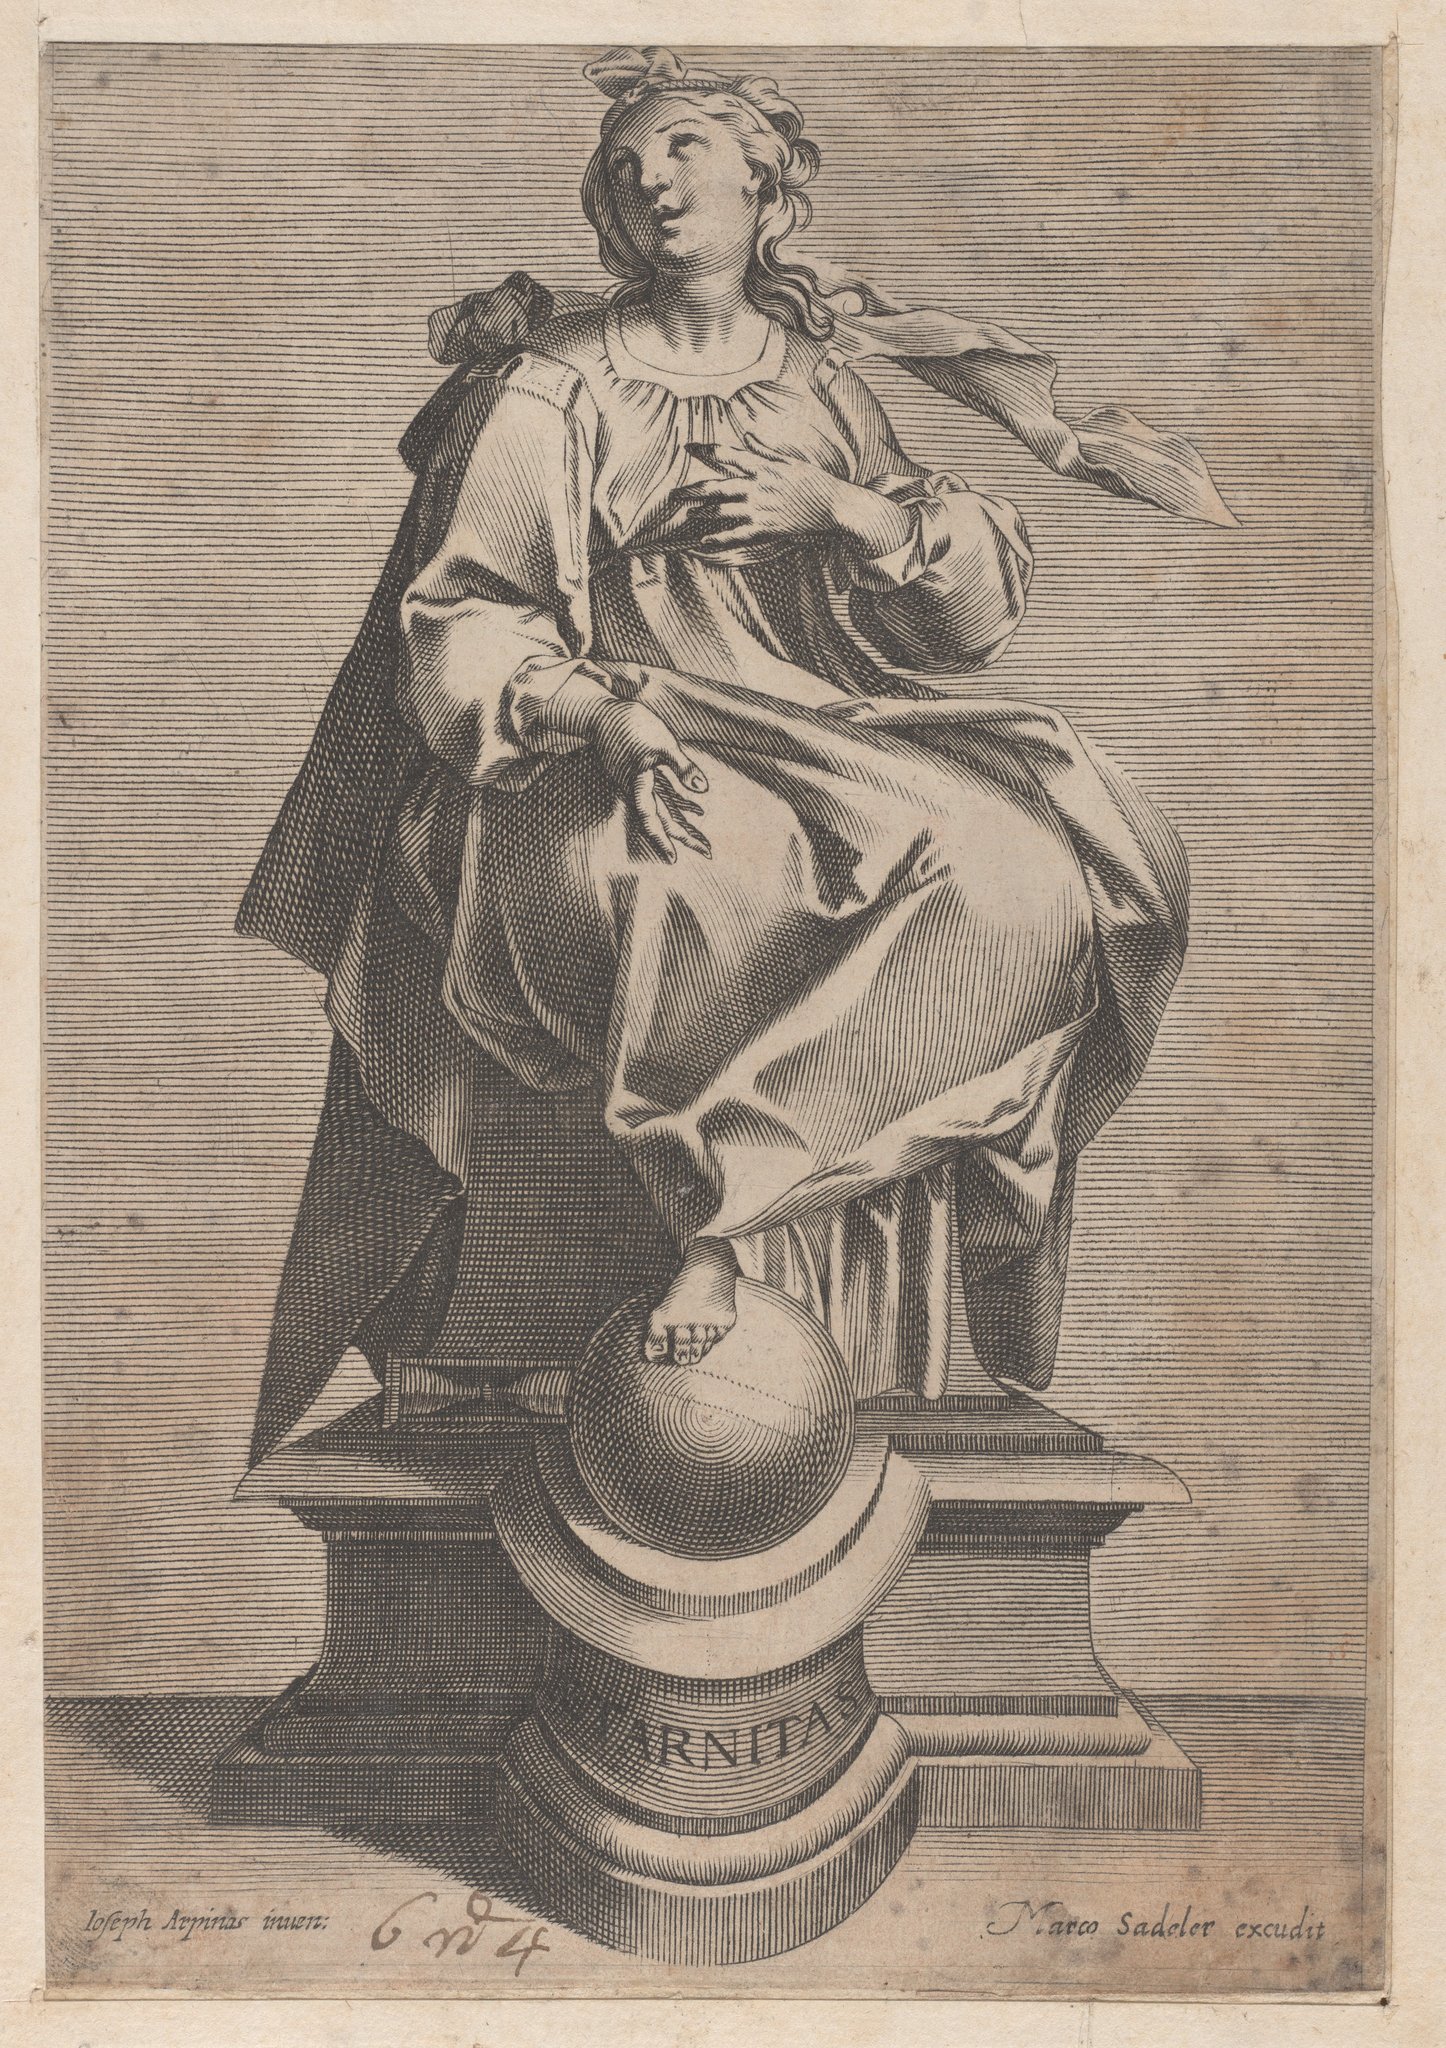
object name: print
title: Aetarnitas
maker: marcus sadeler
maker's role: artist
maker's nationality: flemish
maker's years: 1590-1660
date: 1614-1650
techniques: engraving